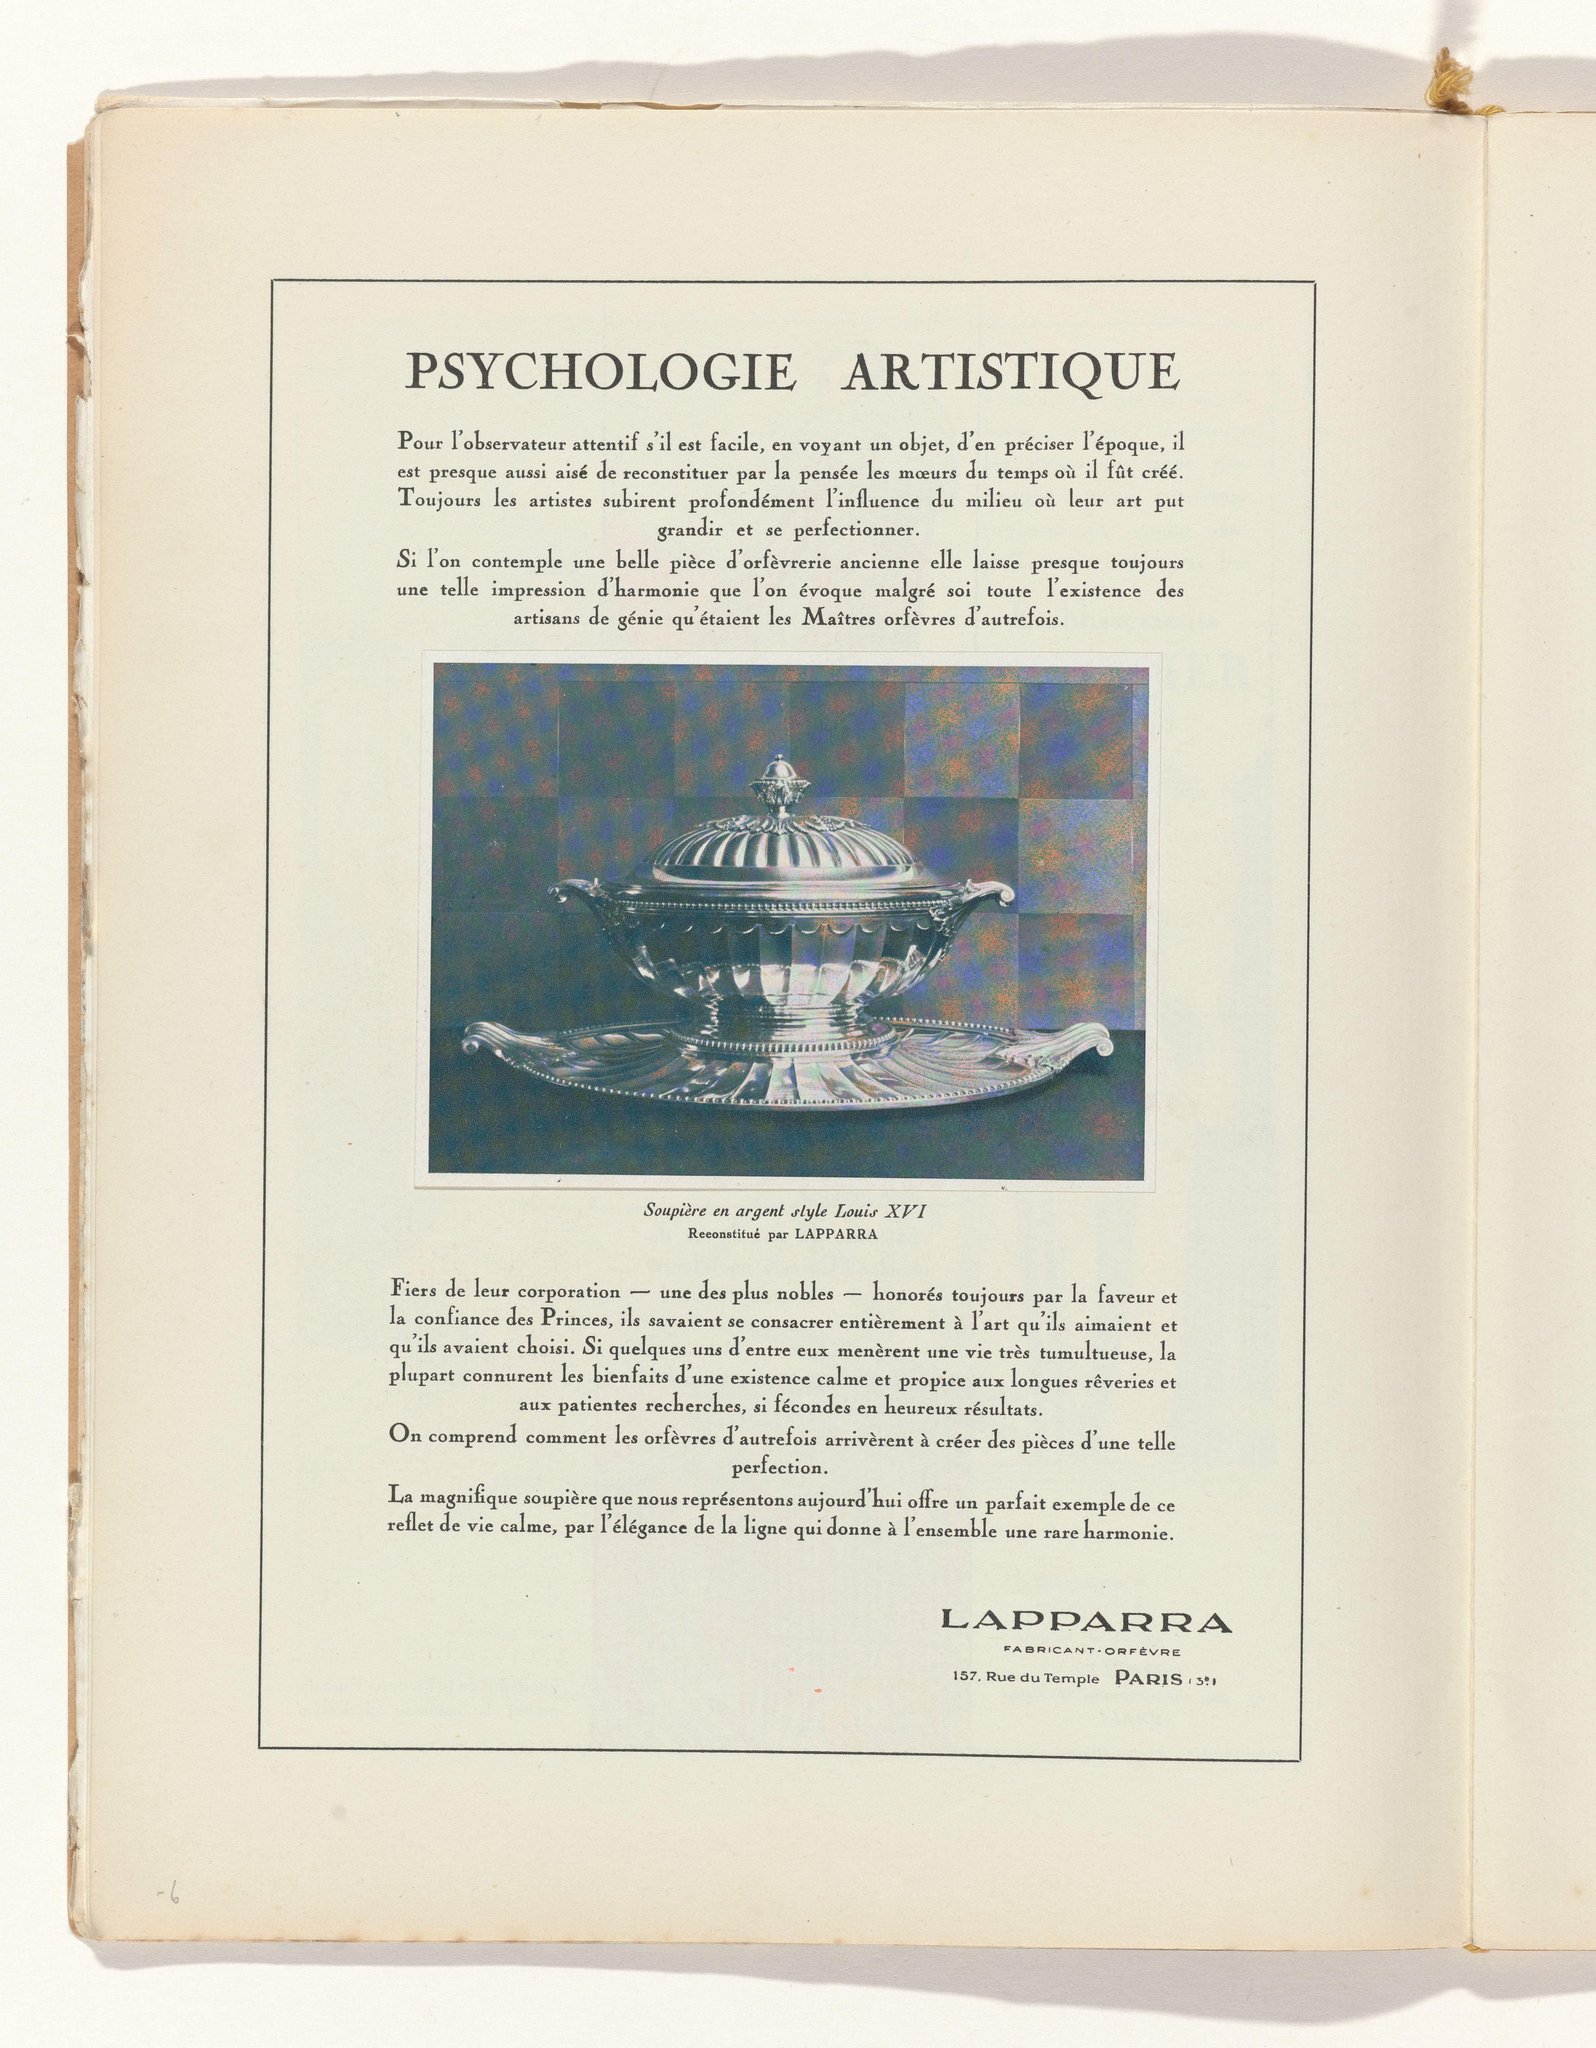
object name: fashion print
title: Art - Goût - Beauté, Feuillets de l' élégance féminine, Novembre 1928, No. 99, 9e Année, p. 6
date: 1928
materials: paper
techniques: lithograph, photography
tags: fashion plates, bowl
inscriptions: title: ‘PSYCHOLOGIE ARTISTIQUE’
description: Advertentie voor een zilveren soepterrine 'style Louis XVI' van Lapparra. Pagina uit het modetijdschrift Art-Goût-Beauté (1920-1933).